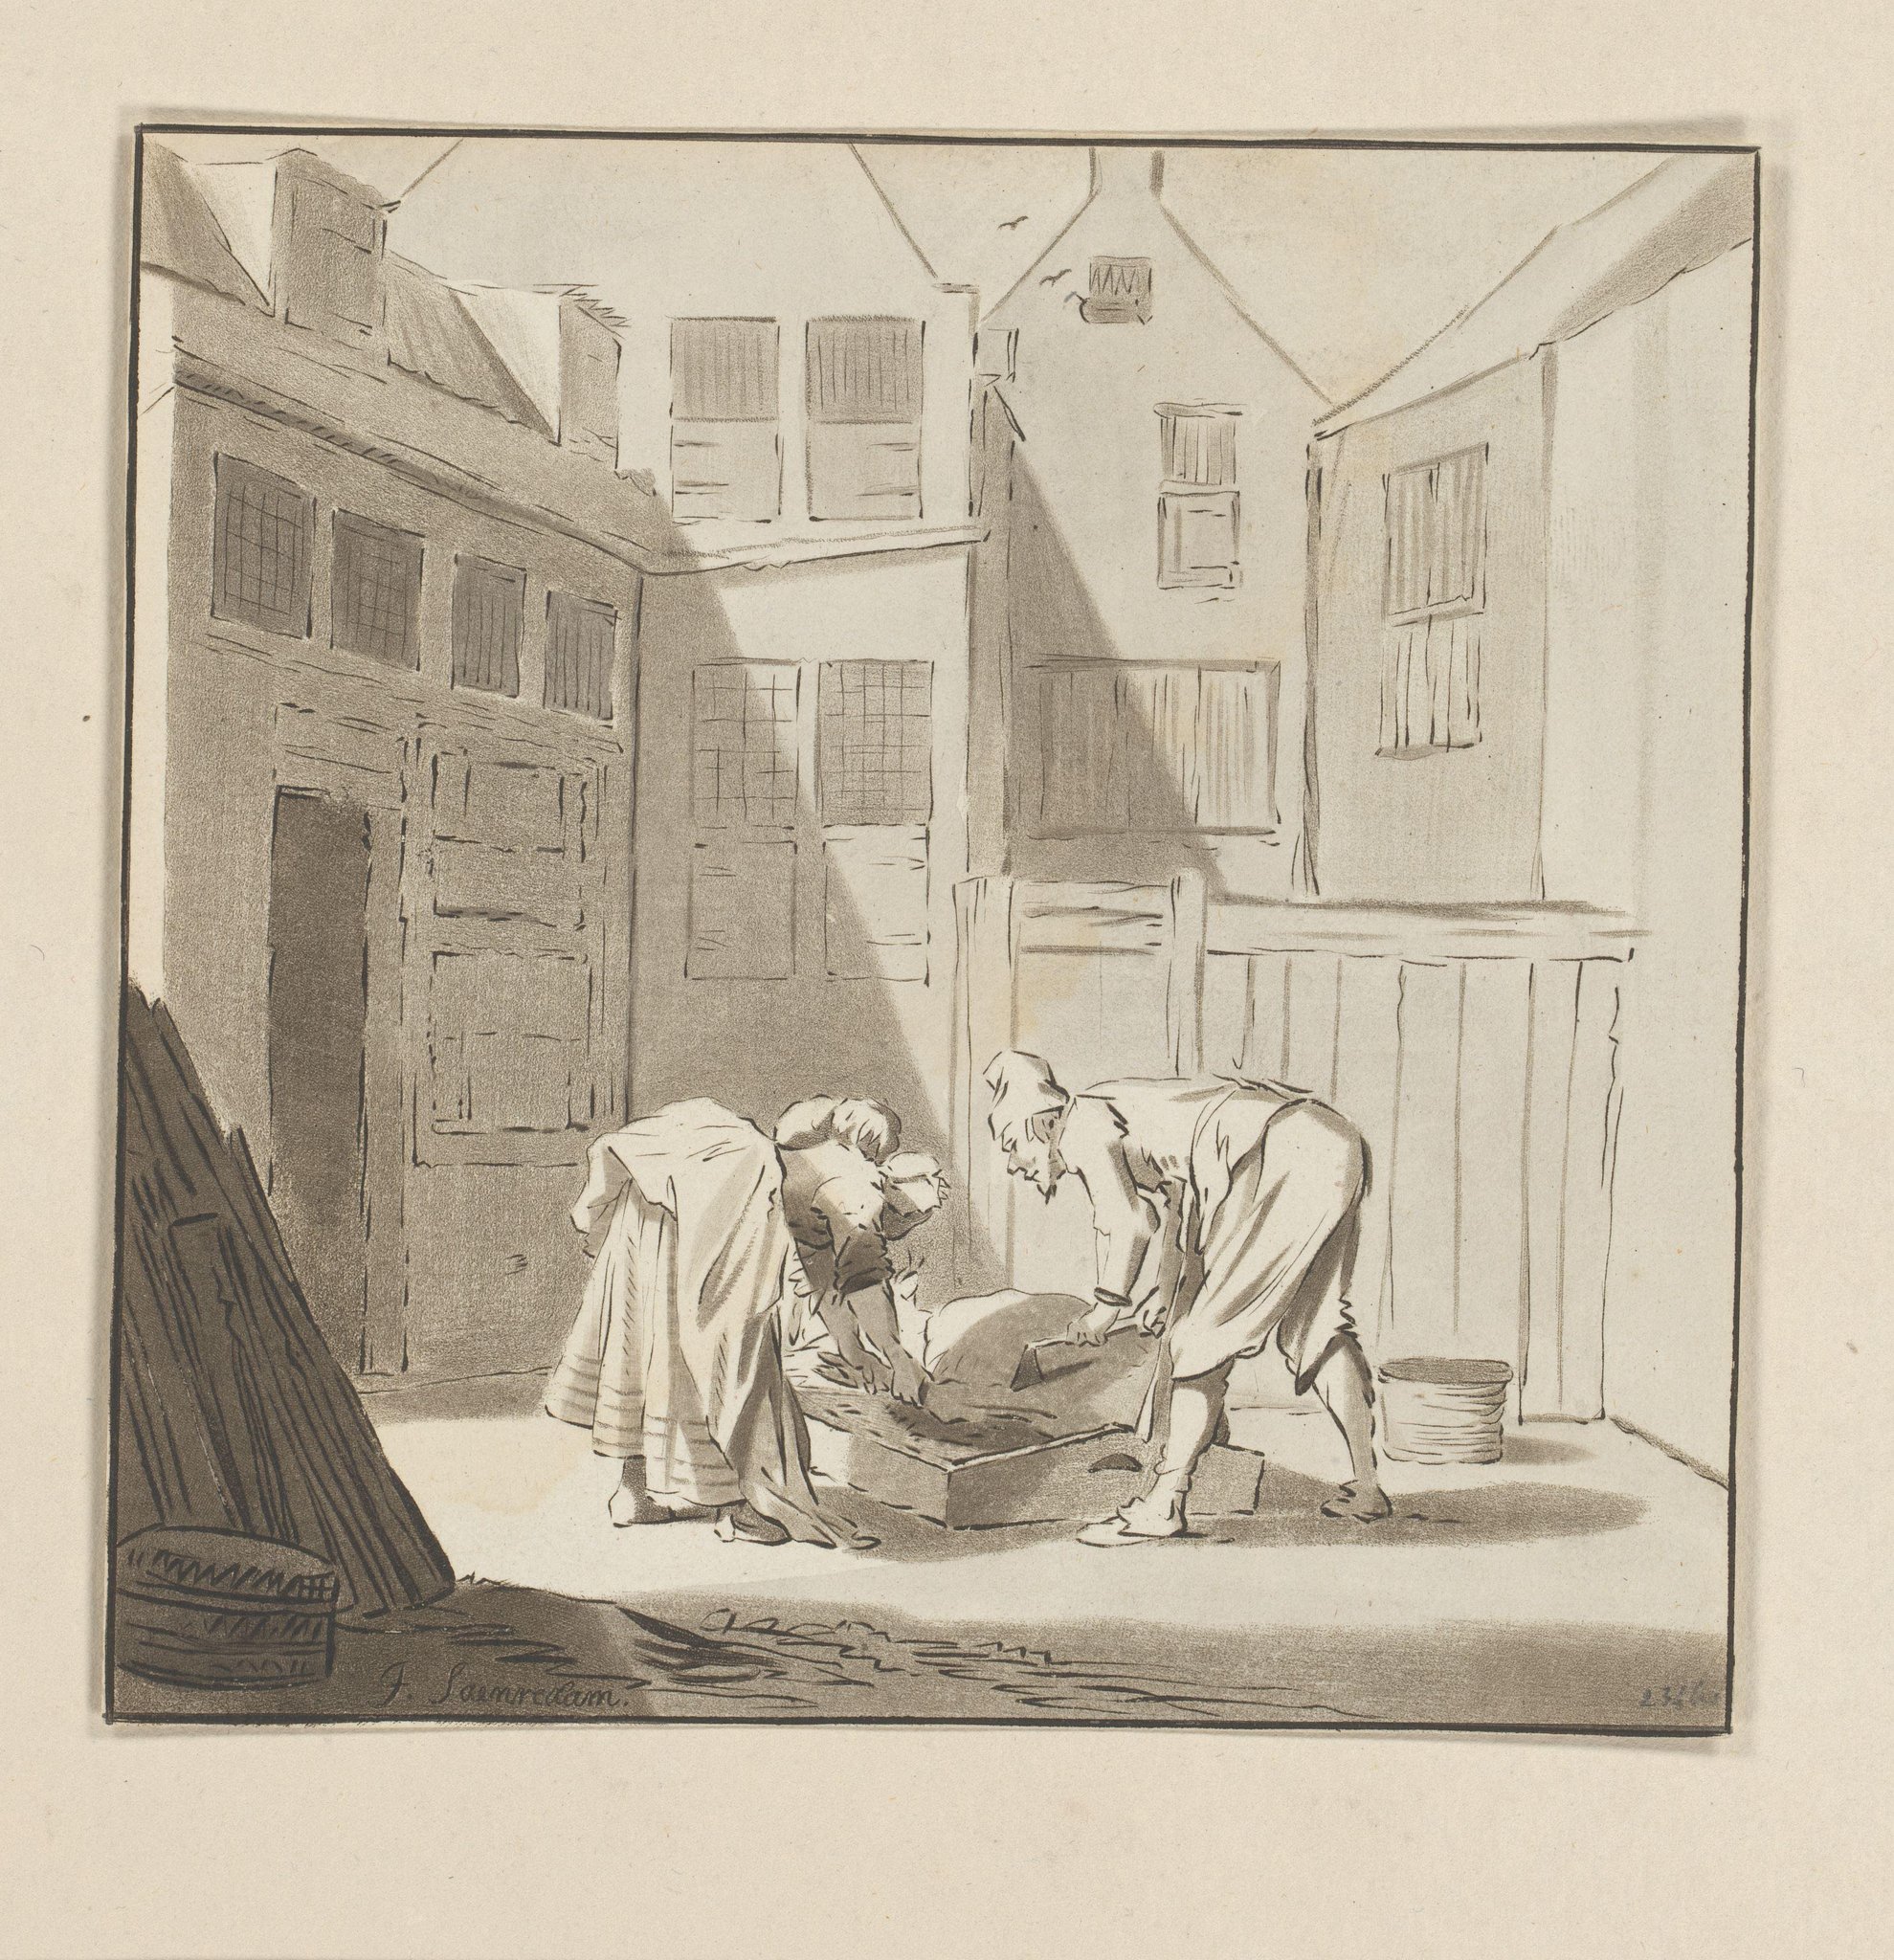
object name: print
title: Varkensslacht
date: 1778-1787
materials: paper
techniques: etching, hand coloring, roulette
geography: amsterdam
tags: slaughtered ox or pig, butcher, slaughterman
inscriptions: collector's mark: Lugt 2725, collector's mark: ‘RIJKS / MUSM’, inscription: ‘J. Saenredam del. 1610. Pl van Amstel fec.’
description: Op een binnenplaats slachten een man en een vrouw een varken. De prent ligt los in een album, zie blad 41.